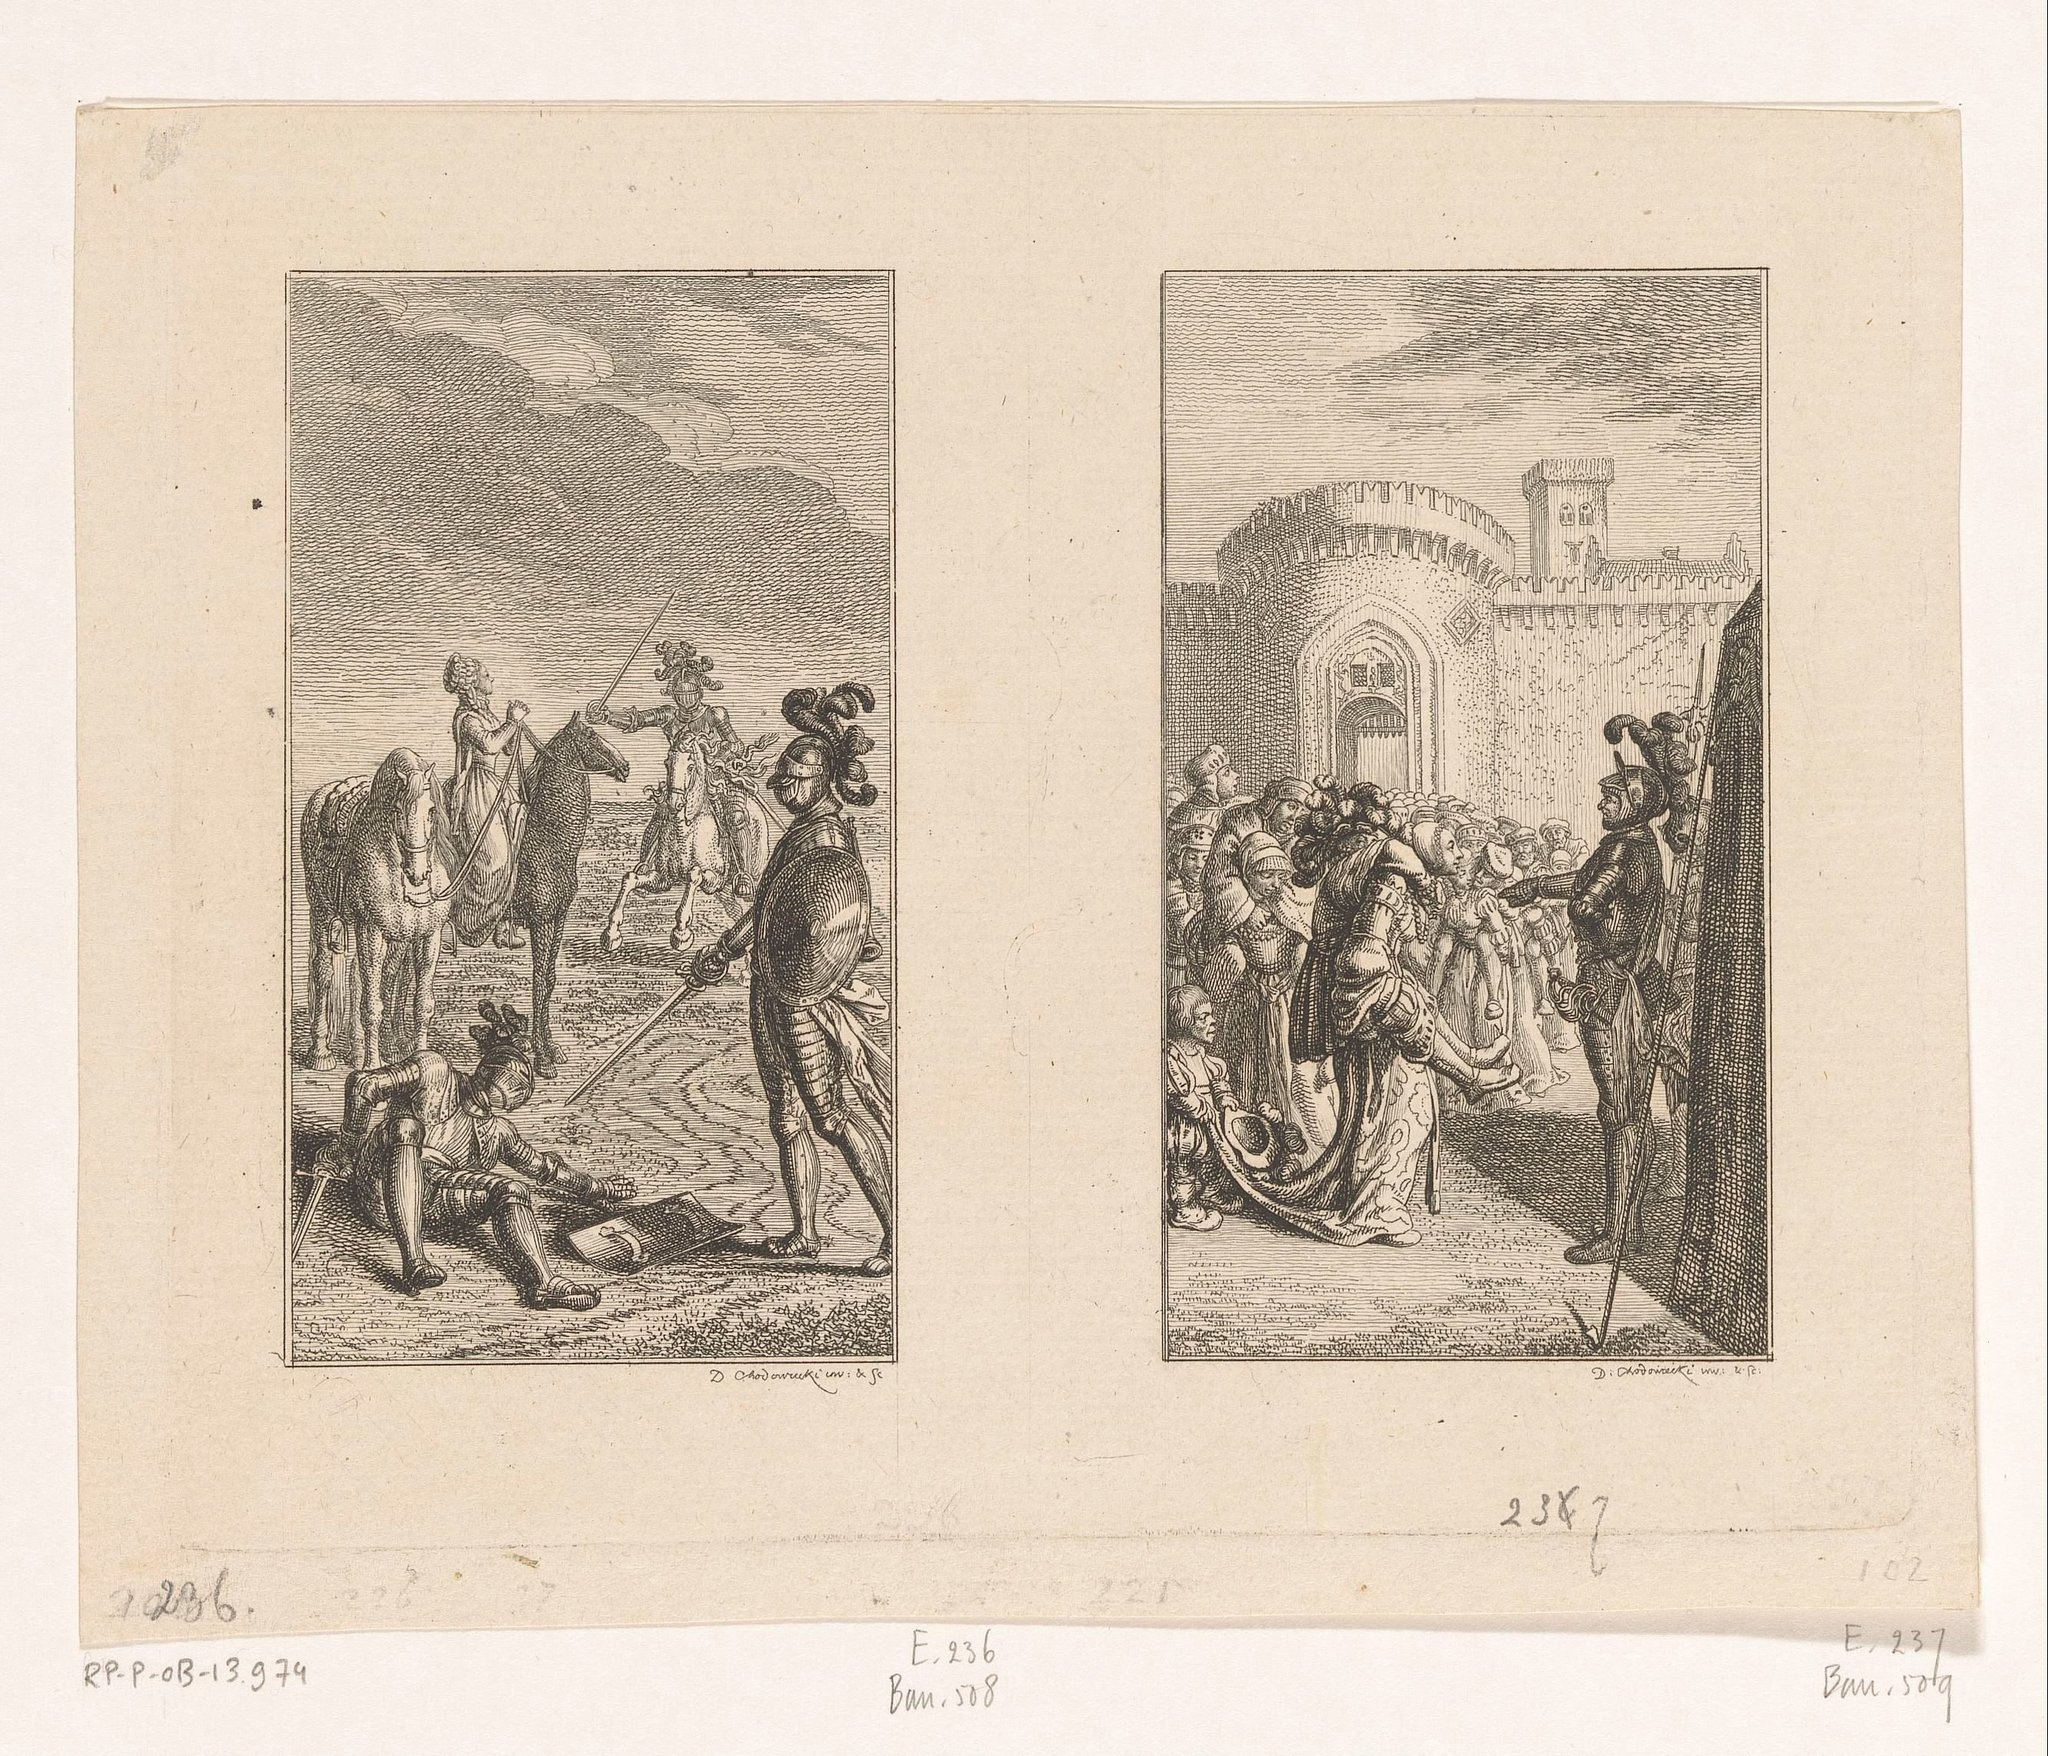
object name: print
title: Twee scènes uit Bürger's Gedichten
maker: daniel nikolaus chodowiecki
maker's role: draughtsman, print maker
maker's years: 1726-1801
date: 1778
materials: paper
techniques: etching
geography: berlin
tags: literature, capture of city (after the siege), carrying a person on one's back, knight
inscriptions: collector's mark: Lugt 2228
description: Links een scène gebaseerd op het gedicht 'Die Entführung, oder Ritter Karl von Eichenhorst und Fräulein Gertrude von Hochburg'. De vader van Gertrud von Hochburg wil dat zij met jonker Plump von Pommerland trouwt, maar zij laat zich schaken door ridder Karl von Eichenhorst, op wie zij verliefd is. Tijdens een duel verslaat Karl von Eichenhorst de jonker en stemt de vader alsnog toe in het huwelijk. Rechts een scène gebaseerd op het gedicht 'Die Weiber von Weinsberg'. Het betreft een bewerking van een bekend verhaal waarbij de vrouwen van de Weinsberg na de verovering van hun stad in 1140 door Koenraad III, hun mannen op de rug de stad uitdragen.